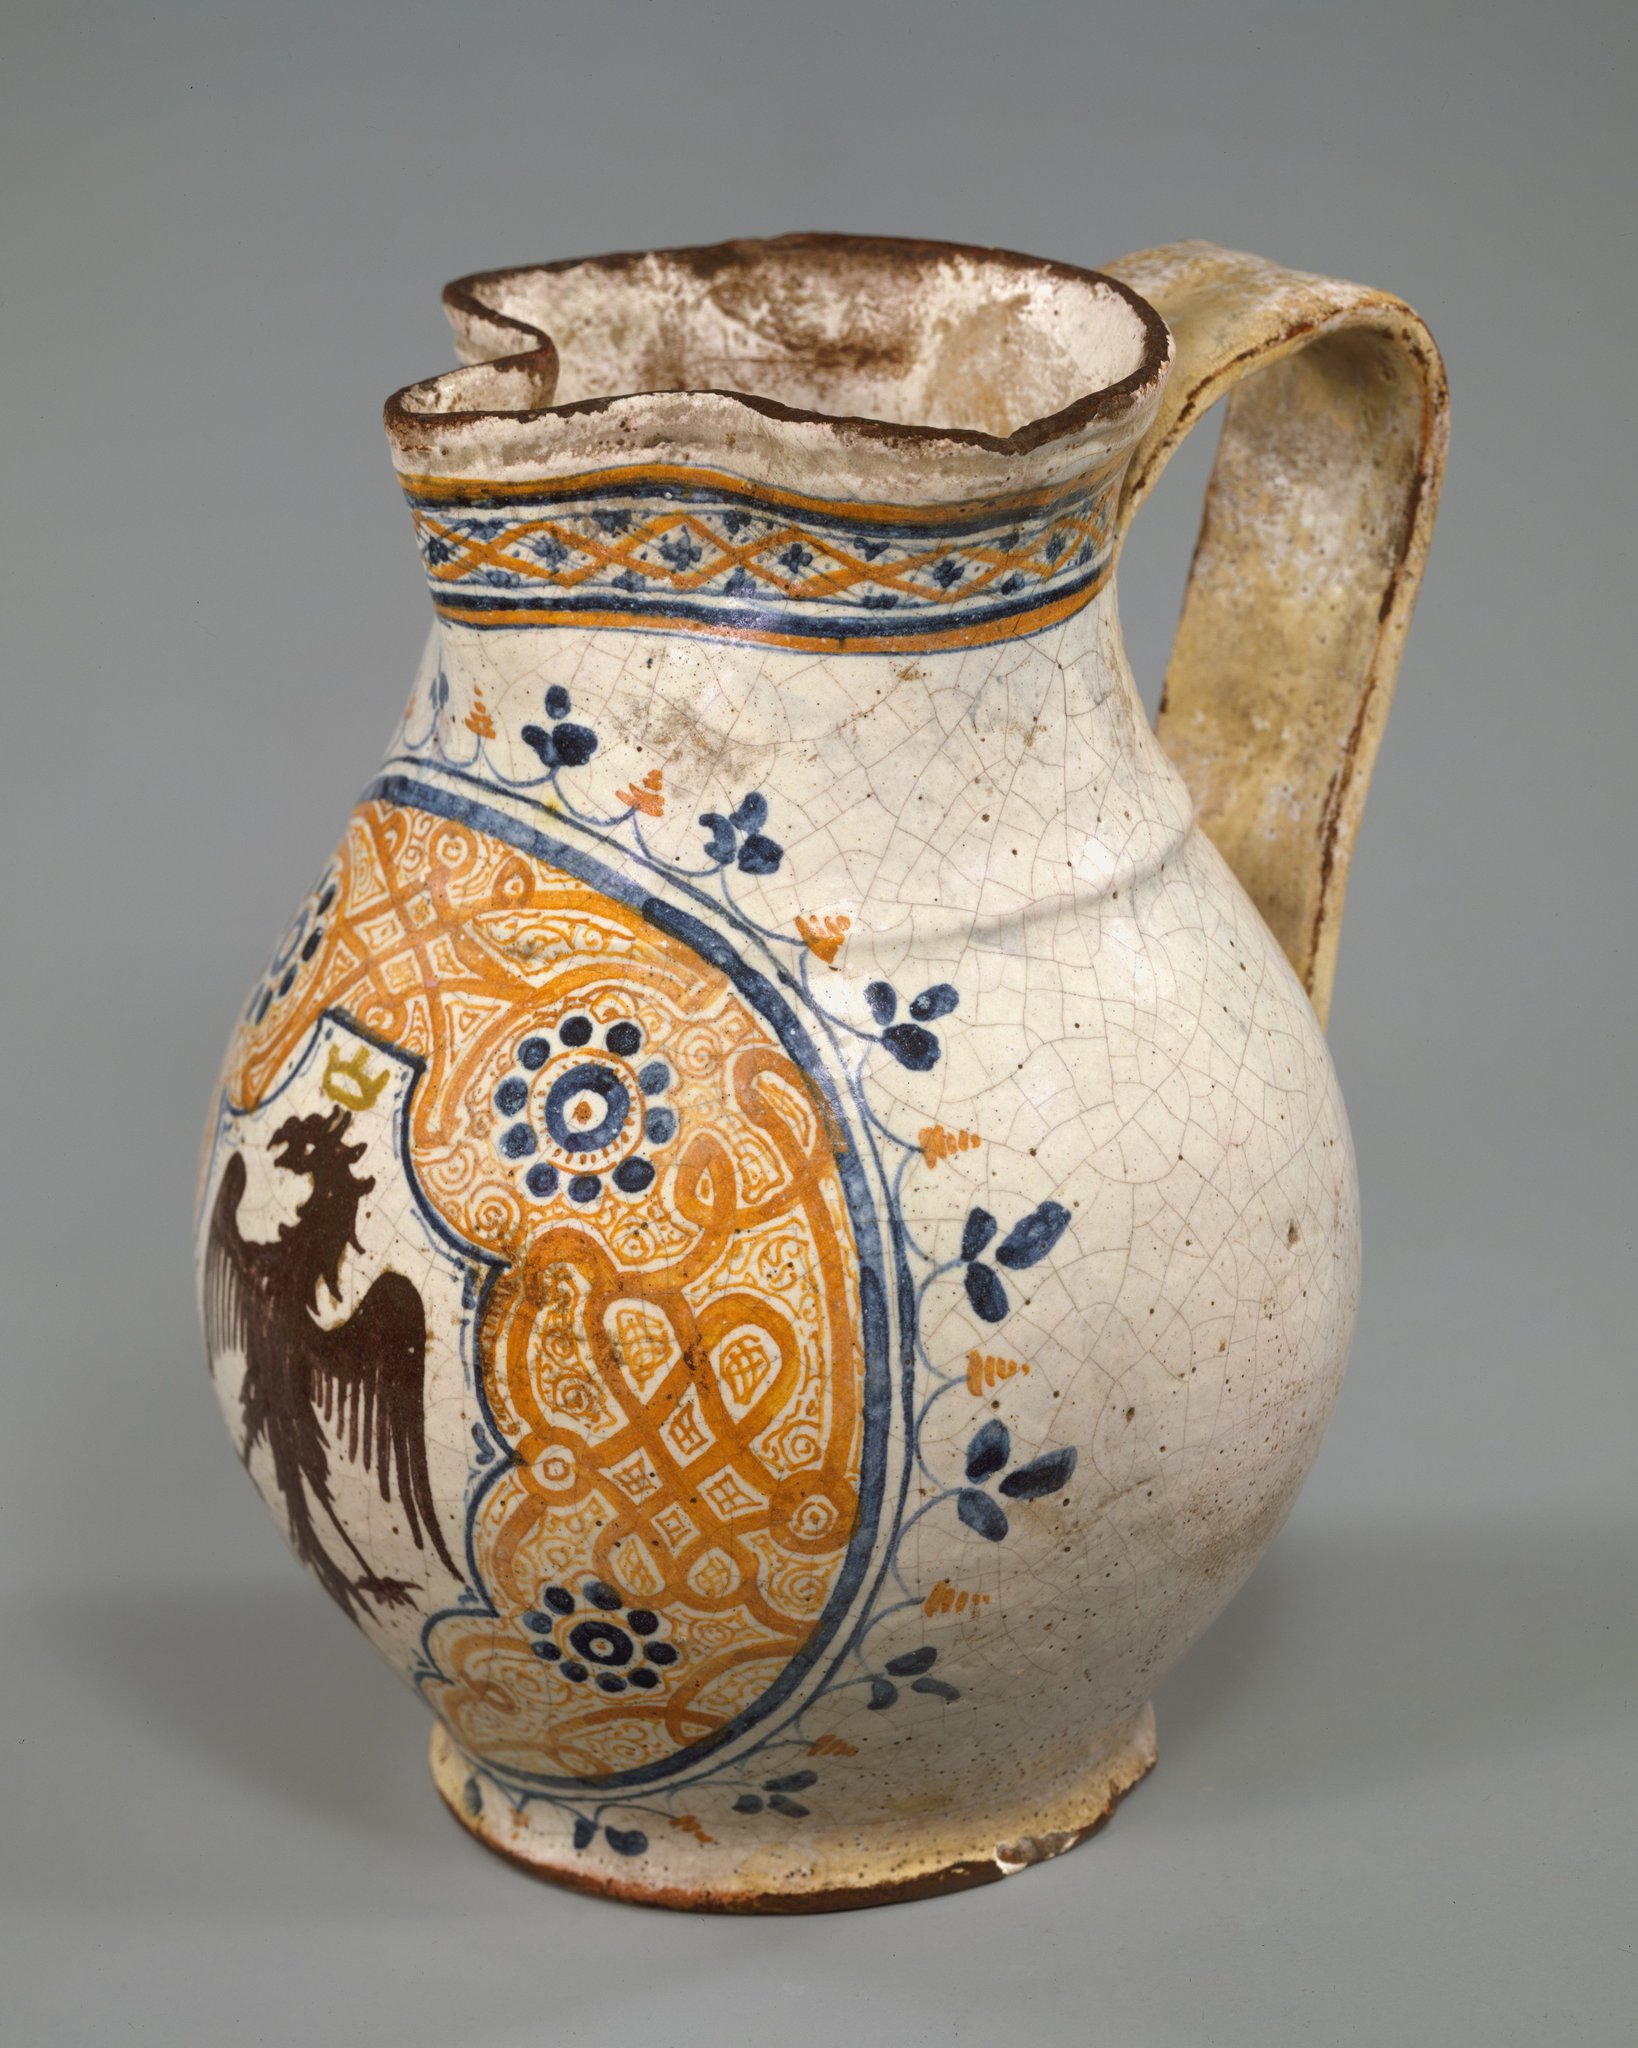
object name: jug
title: Armorial Jug (boccale)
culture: italian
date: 1467-1500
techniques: maiolica, glazing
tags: eagles